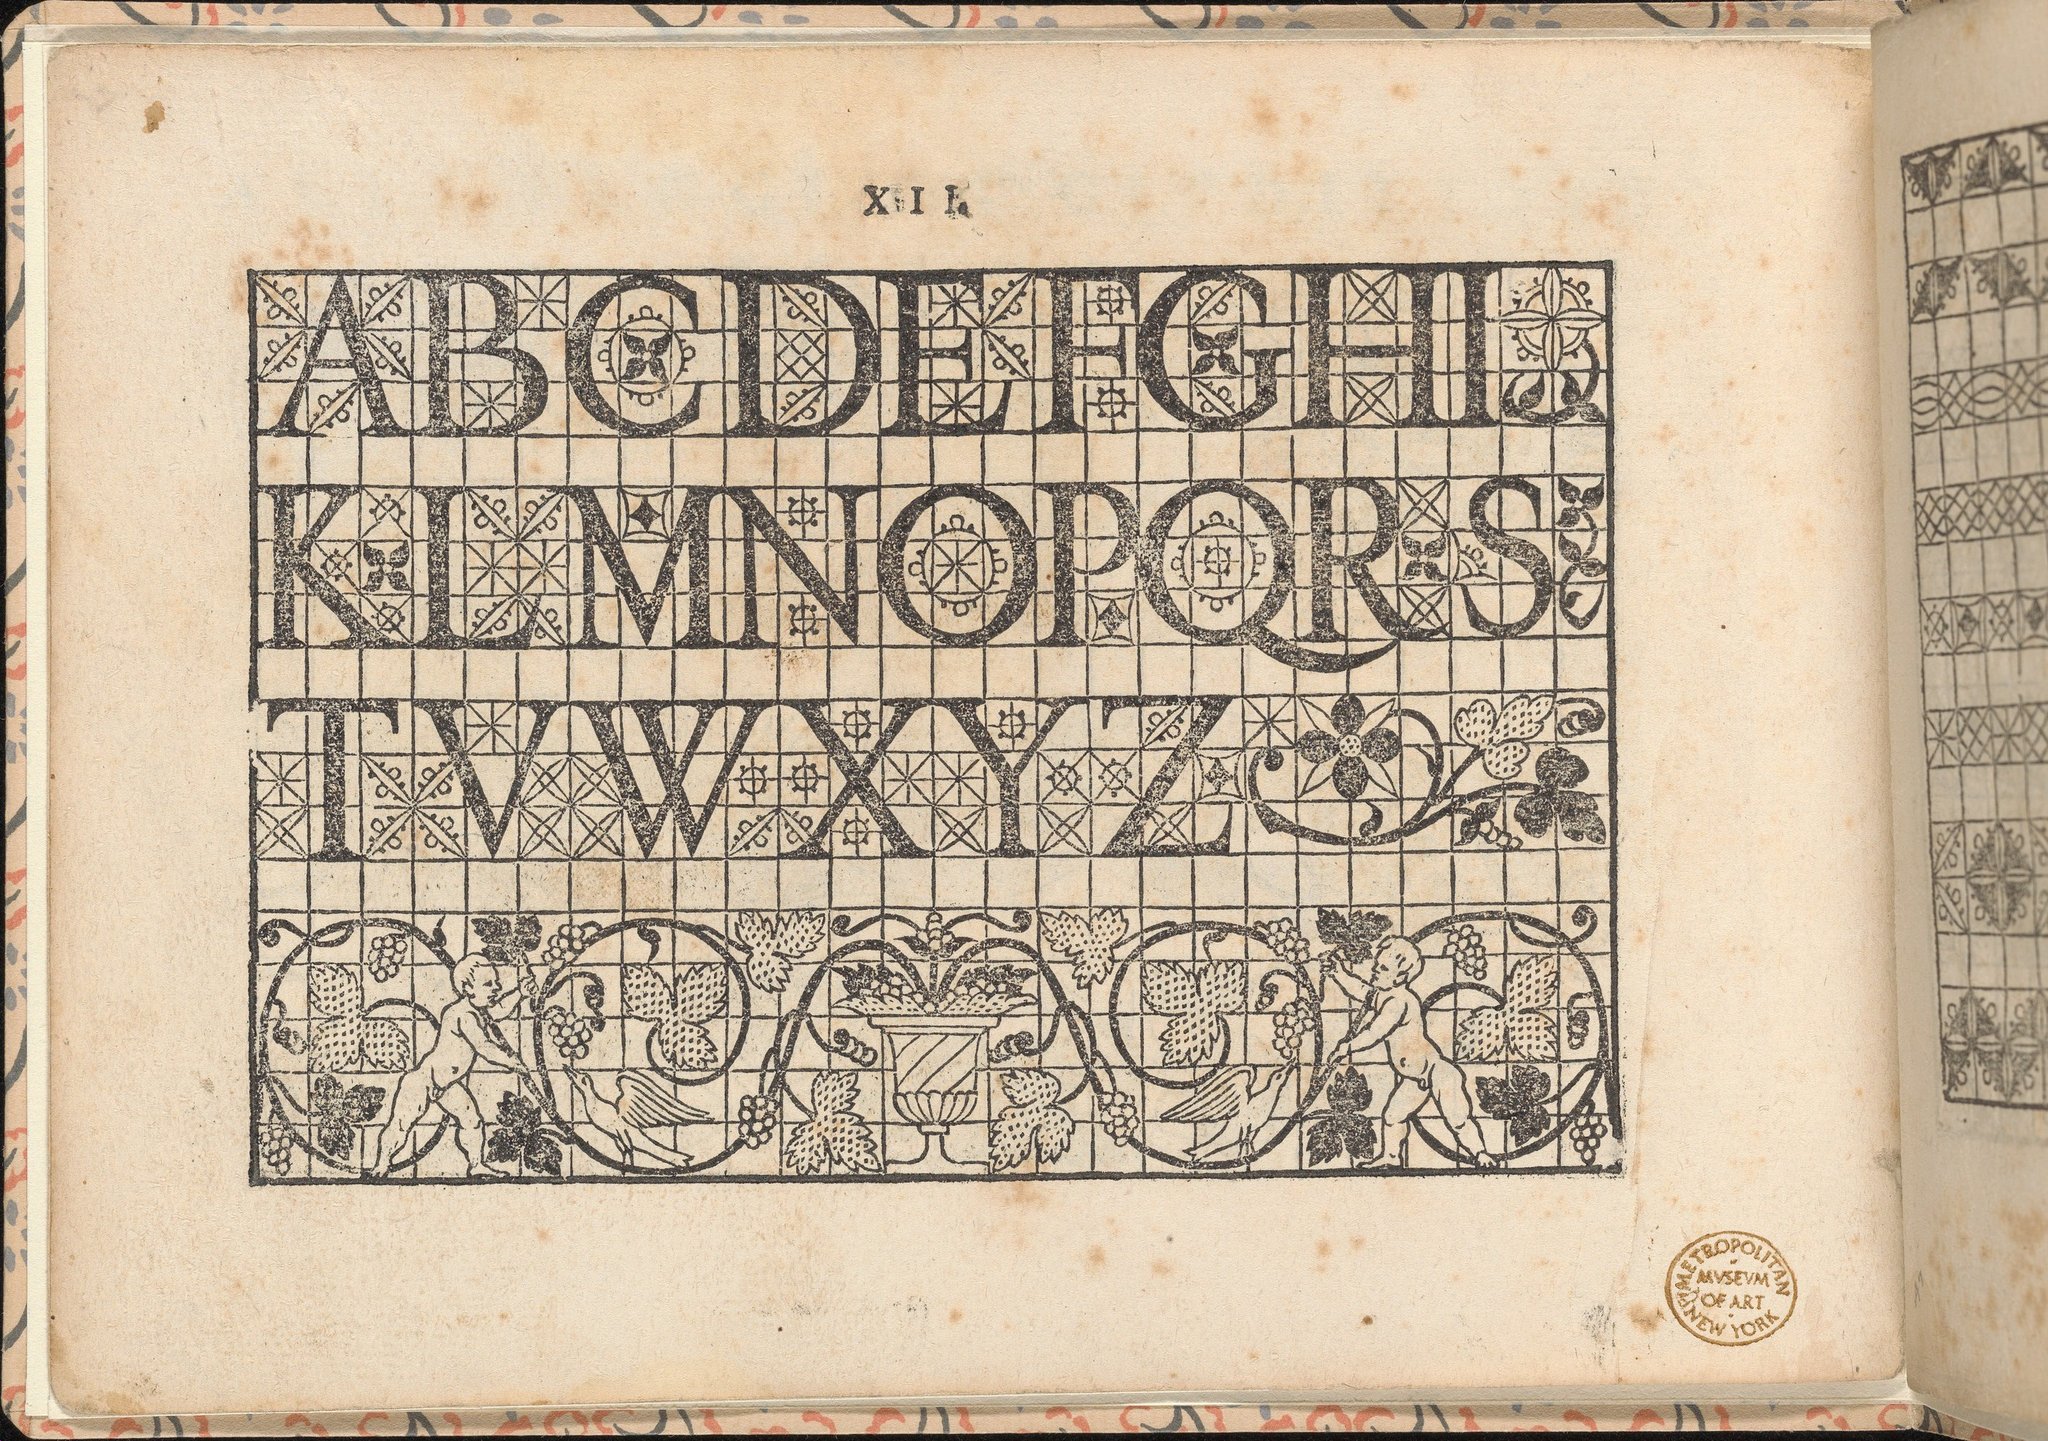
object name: book print ornament architecture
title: La vera perfettione del disegno di varie sorti di recami, page 3 (verso)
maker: giovanni ostaus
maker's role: publisher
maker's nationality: italian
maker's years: 1507-1607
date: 1557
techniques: woodcut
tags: grapes,flowers,vines